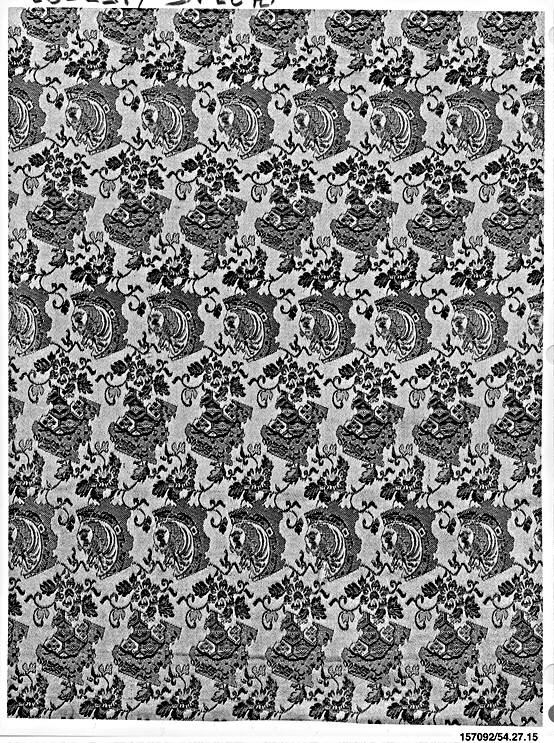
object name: piece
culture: japanese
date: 1867-1933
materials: metal thread, silk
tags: flowers,leaves